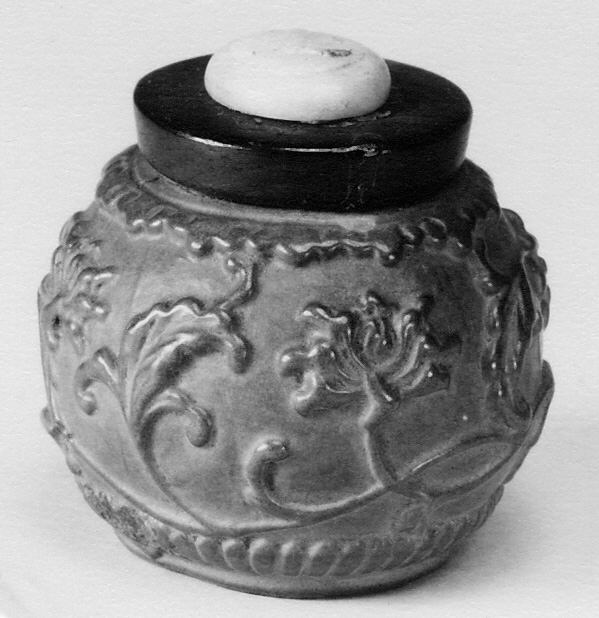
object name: snuff bottle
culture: chinese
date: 1821-1850